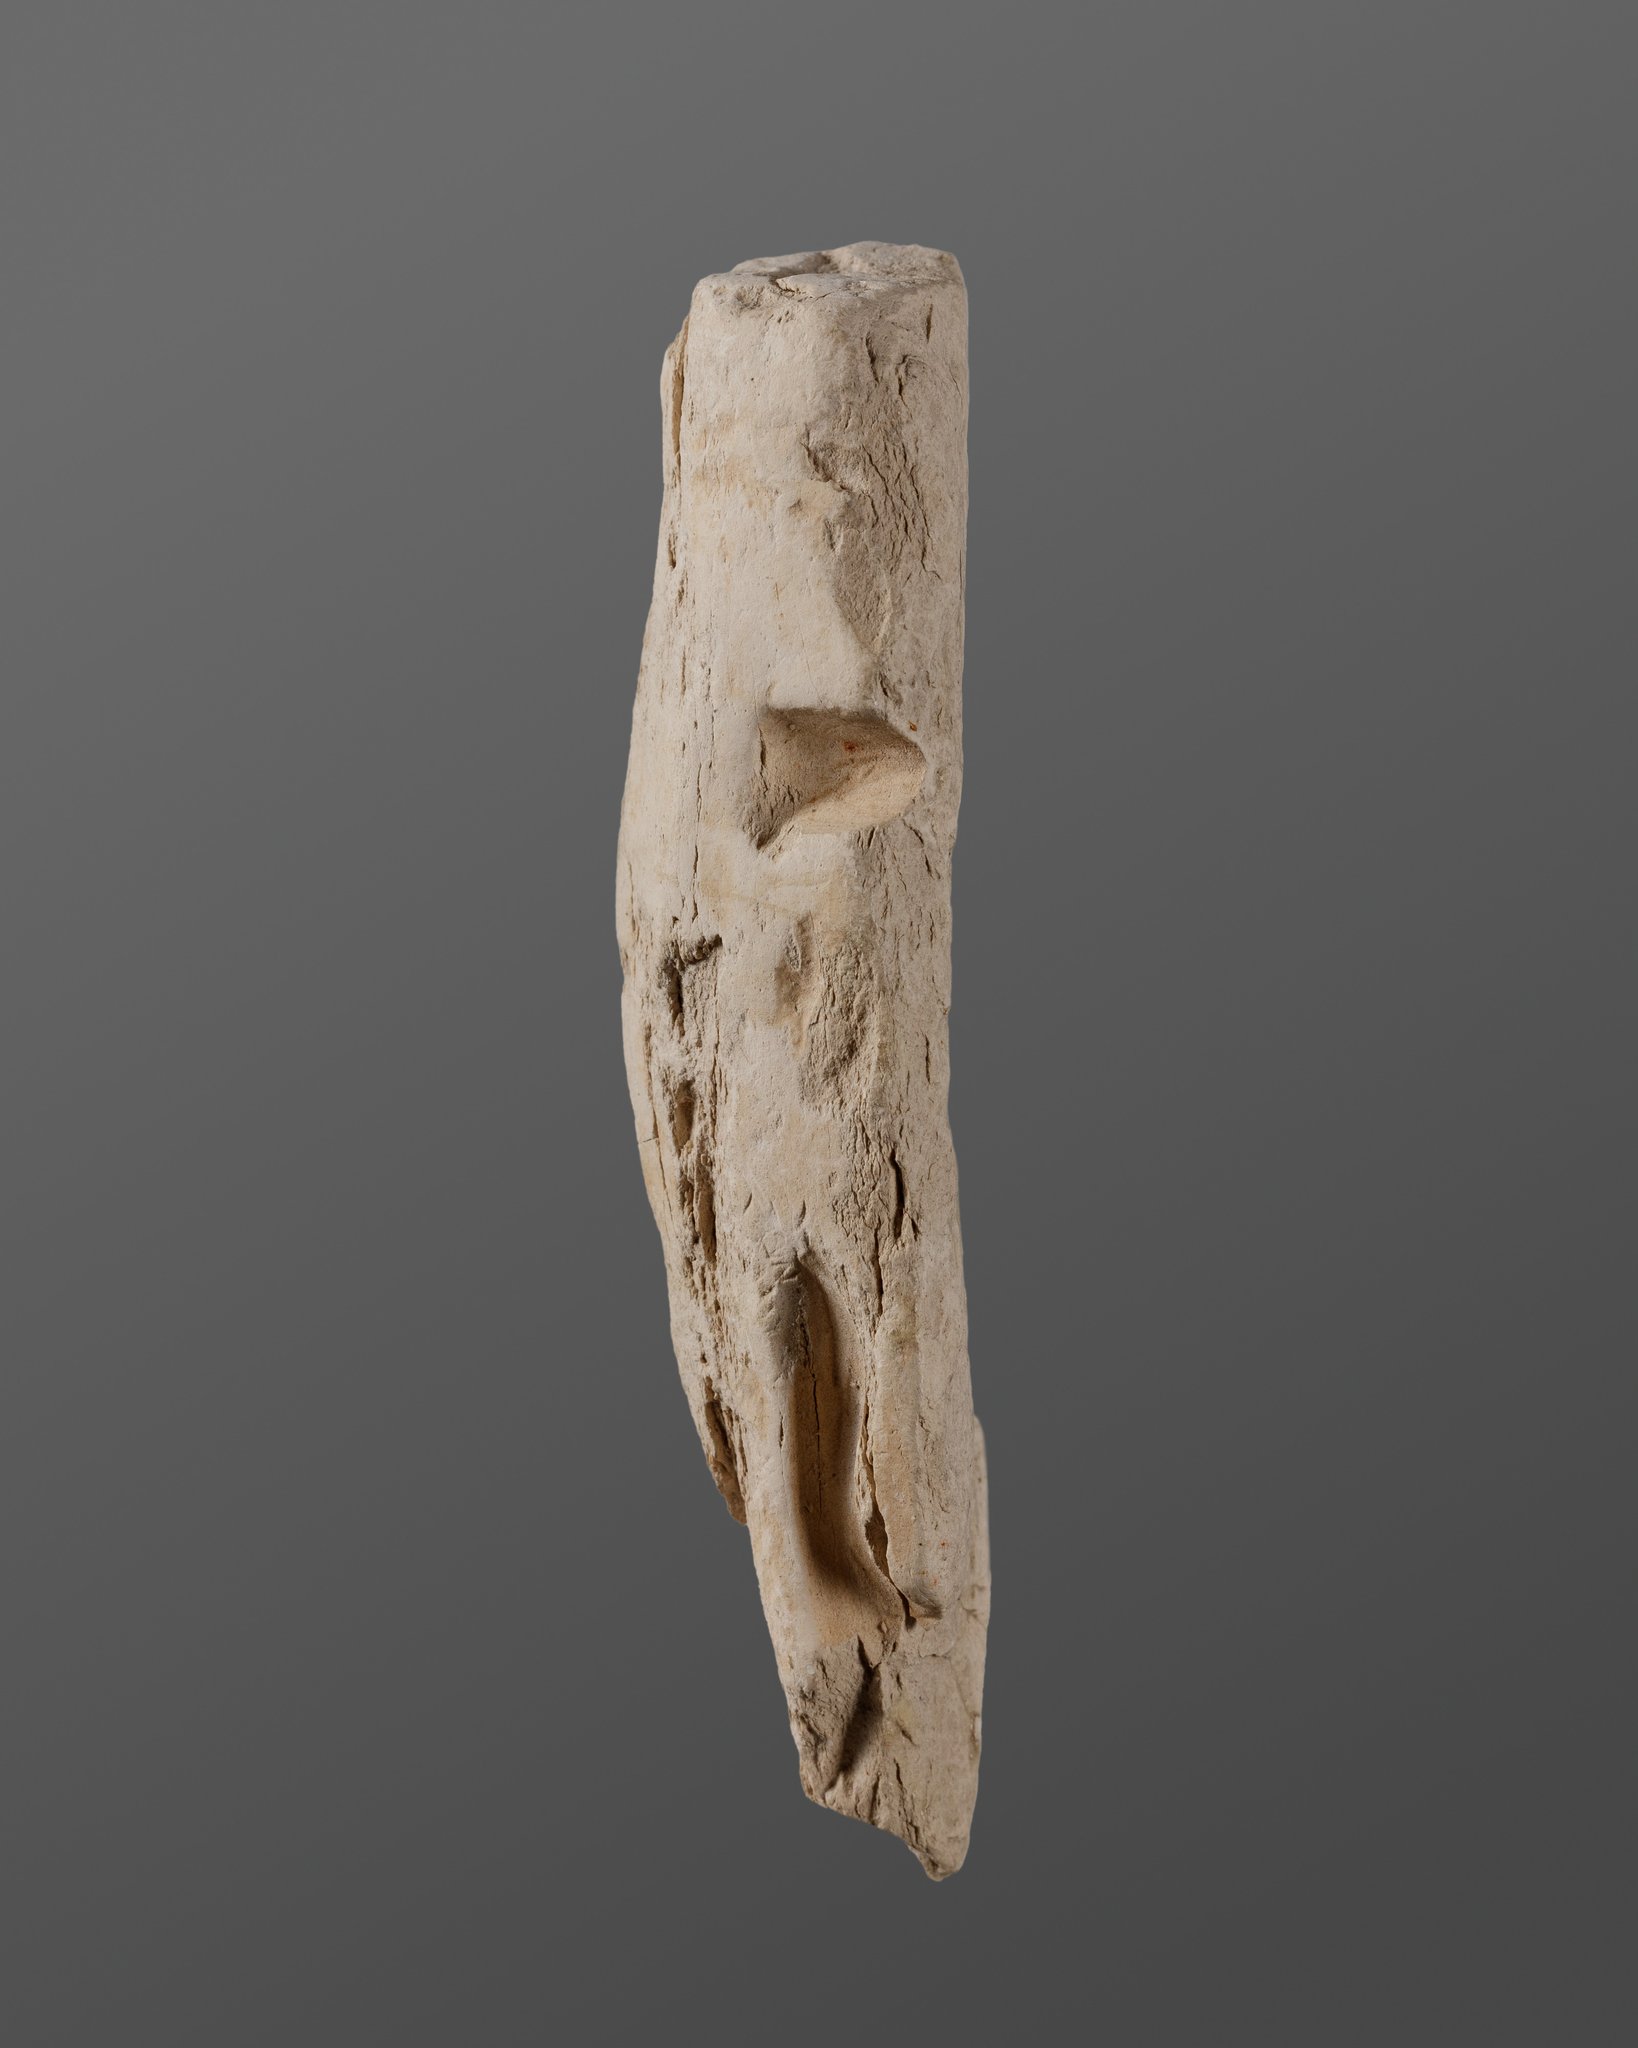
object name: relief fragment 47, tomb of mereri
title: Relief fragment possibly from the tomb of Mereri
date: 2100-2090 BCE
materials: limestone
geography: egypt